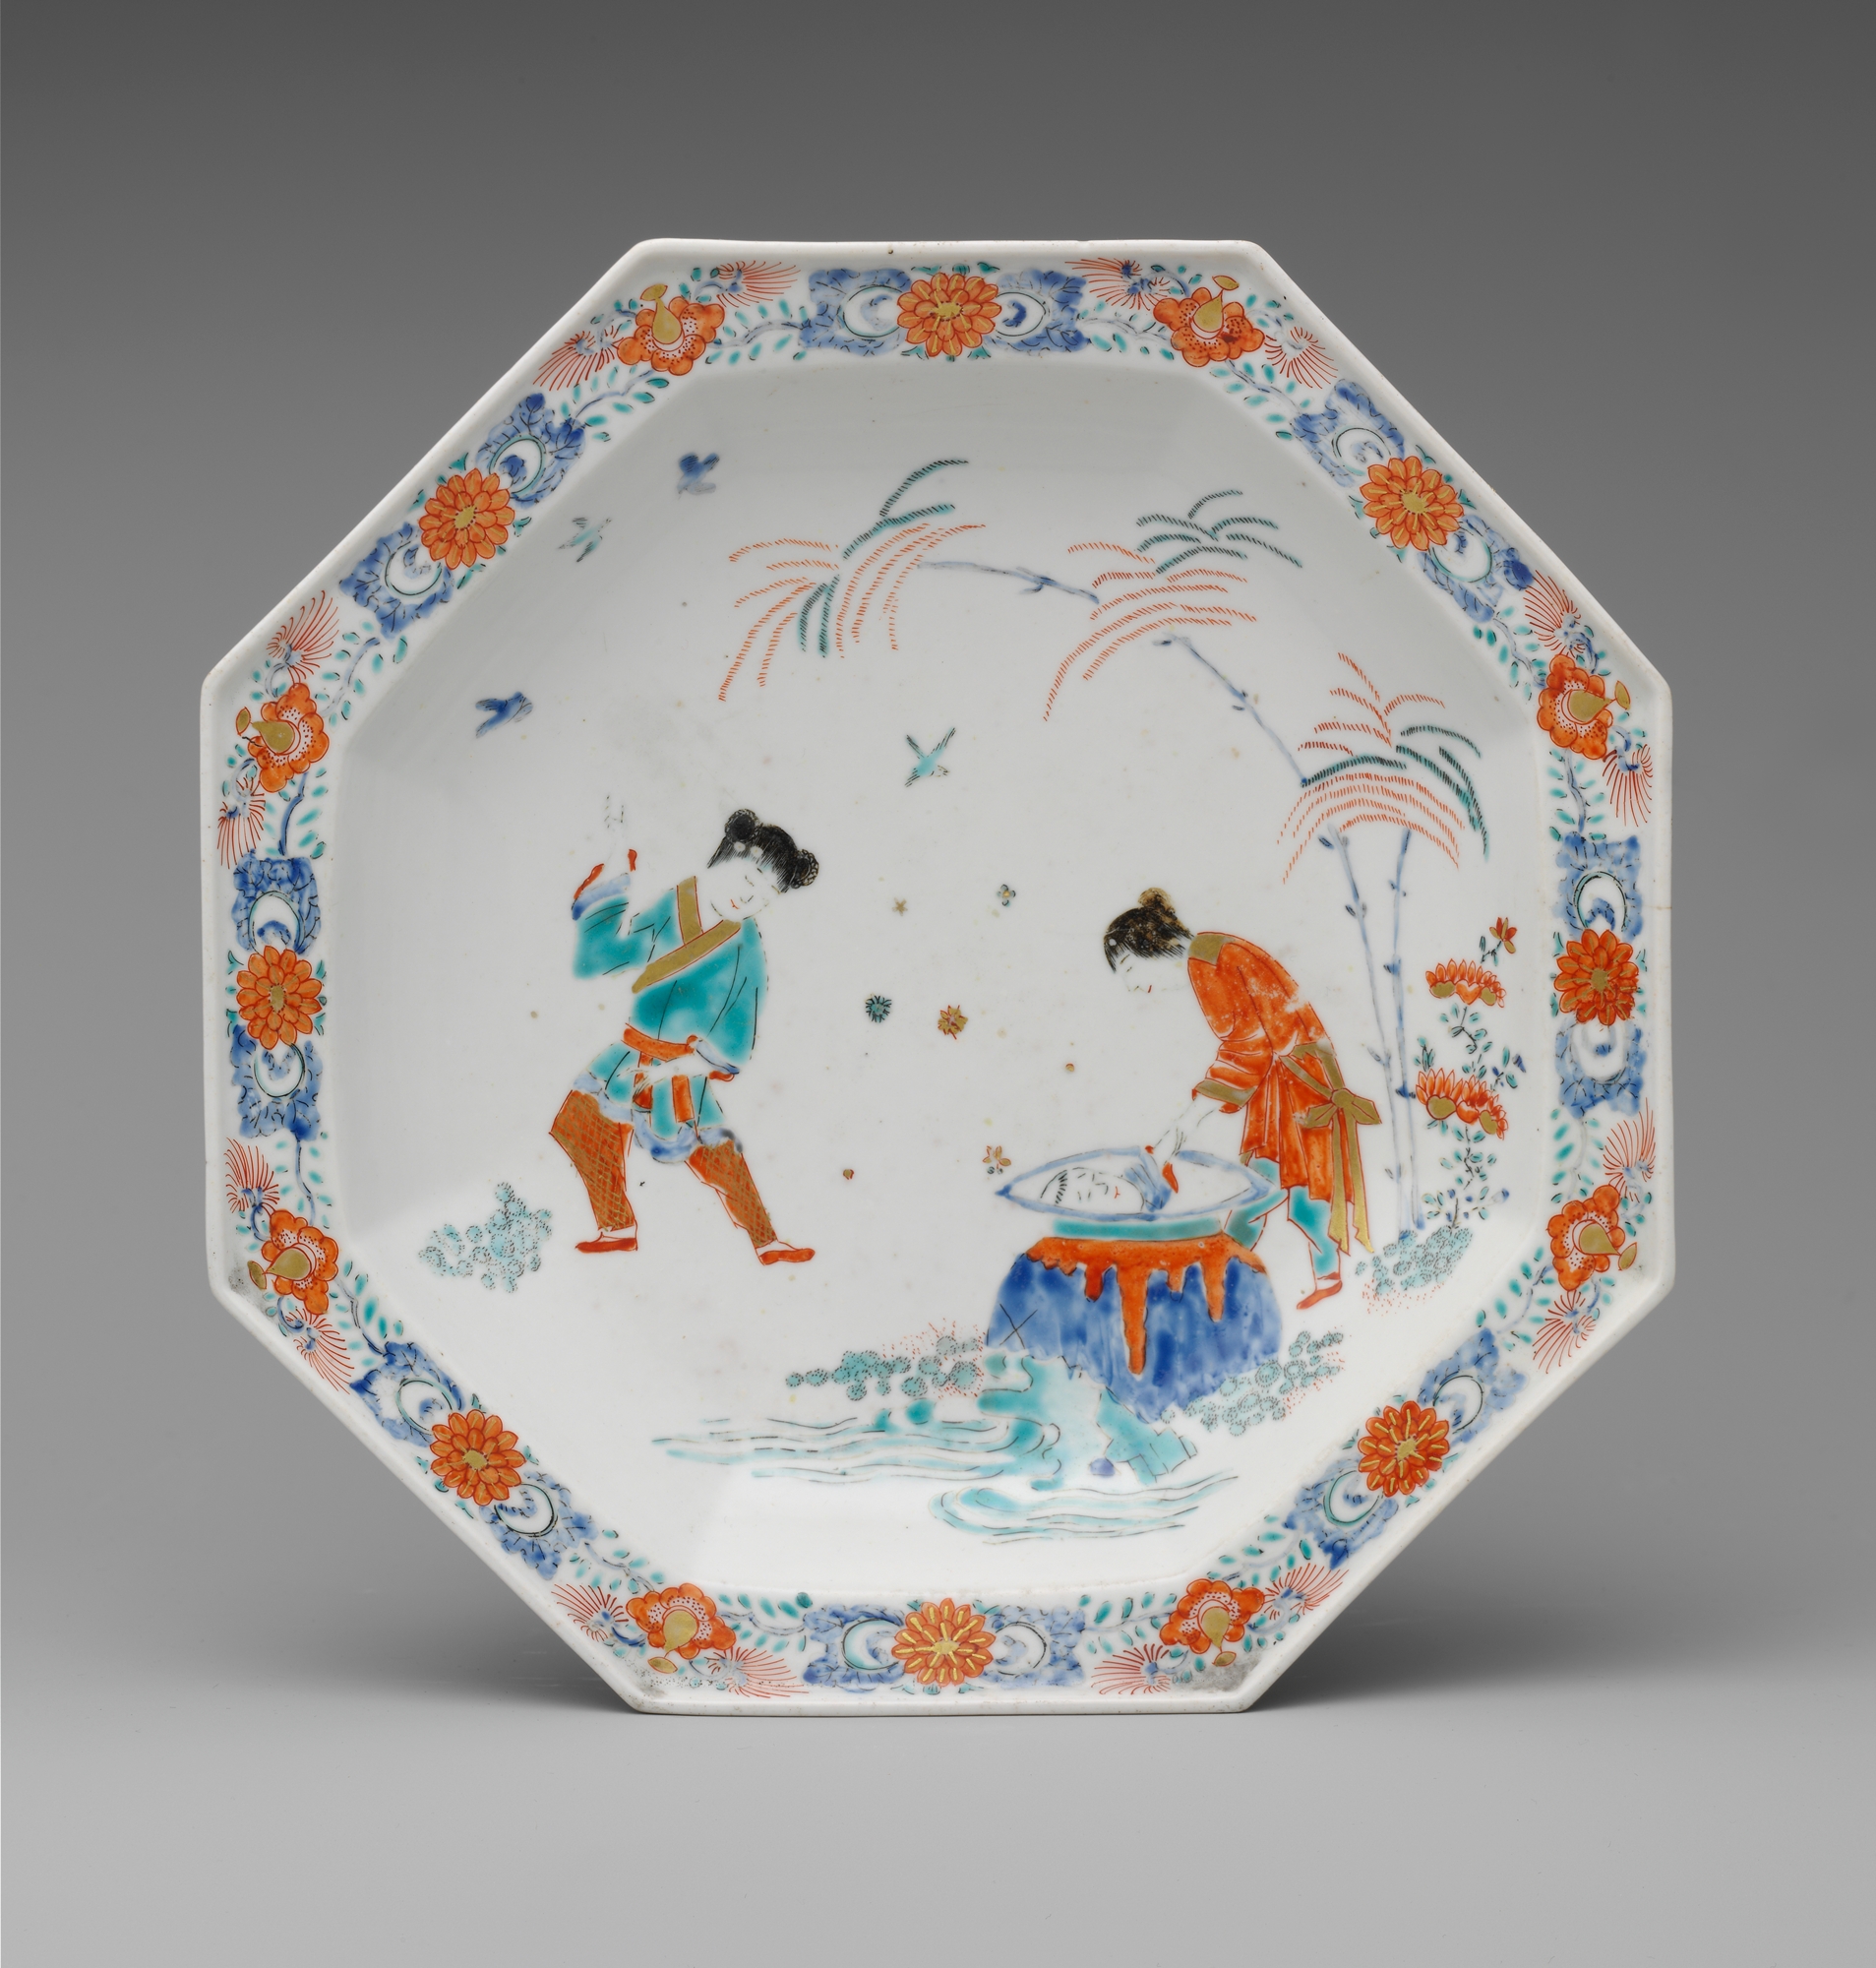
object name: plate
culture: japanese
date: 1800-1900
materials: porcelain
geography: japan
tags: human figures,flowers